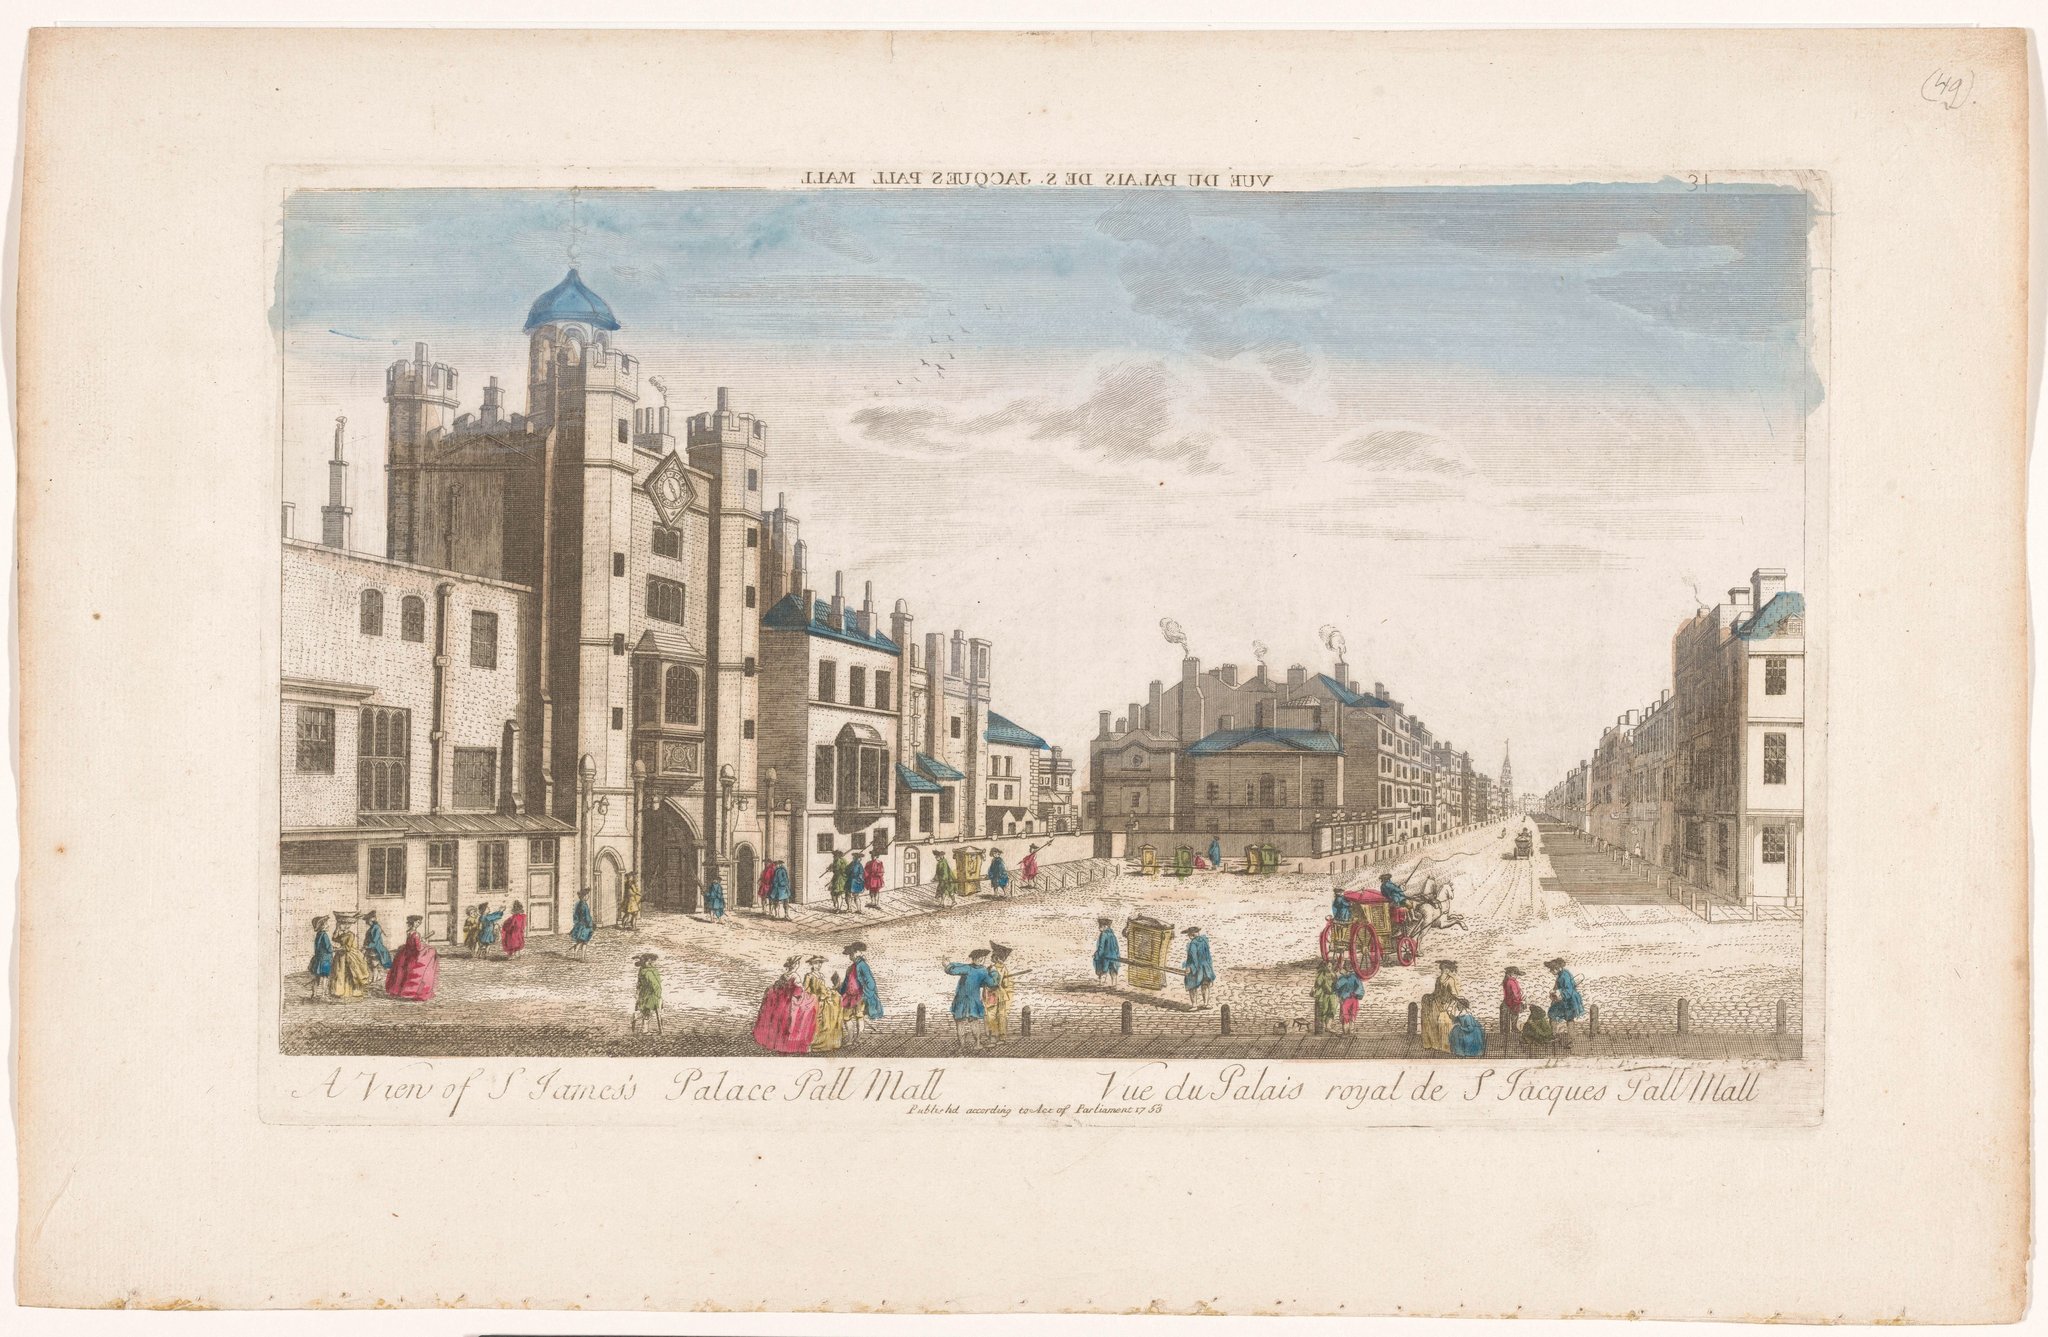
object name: print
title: A view of S James's Palace Pall Mall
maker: Anonymous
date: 1753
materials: paper, watercolor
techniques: brush, etching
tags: palace, street (+ city(-scape) with figures, staffage)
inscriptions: collector's mark: Lugt 2166, watermark: